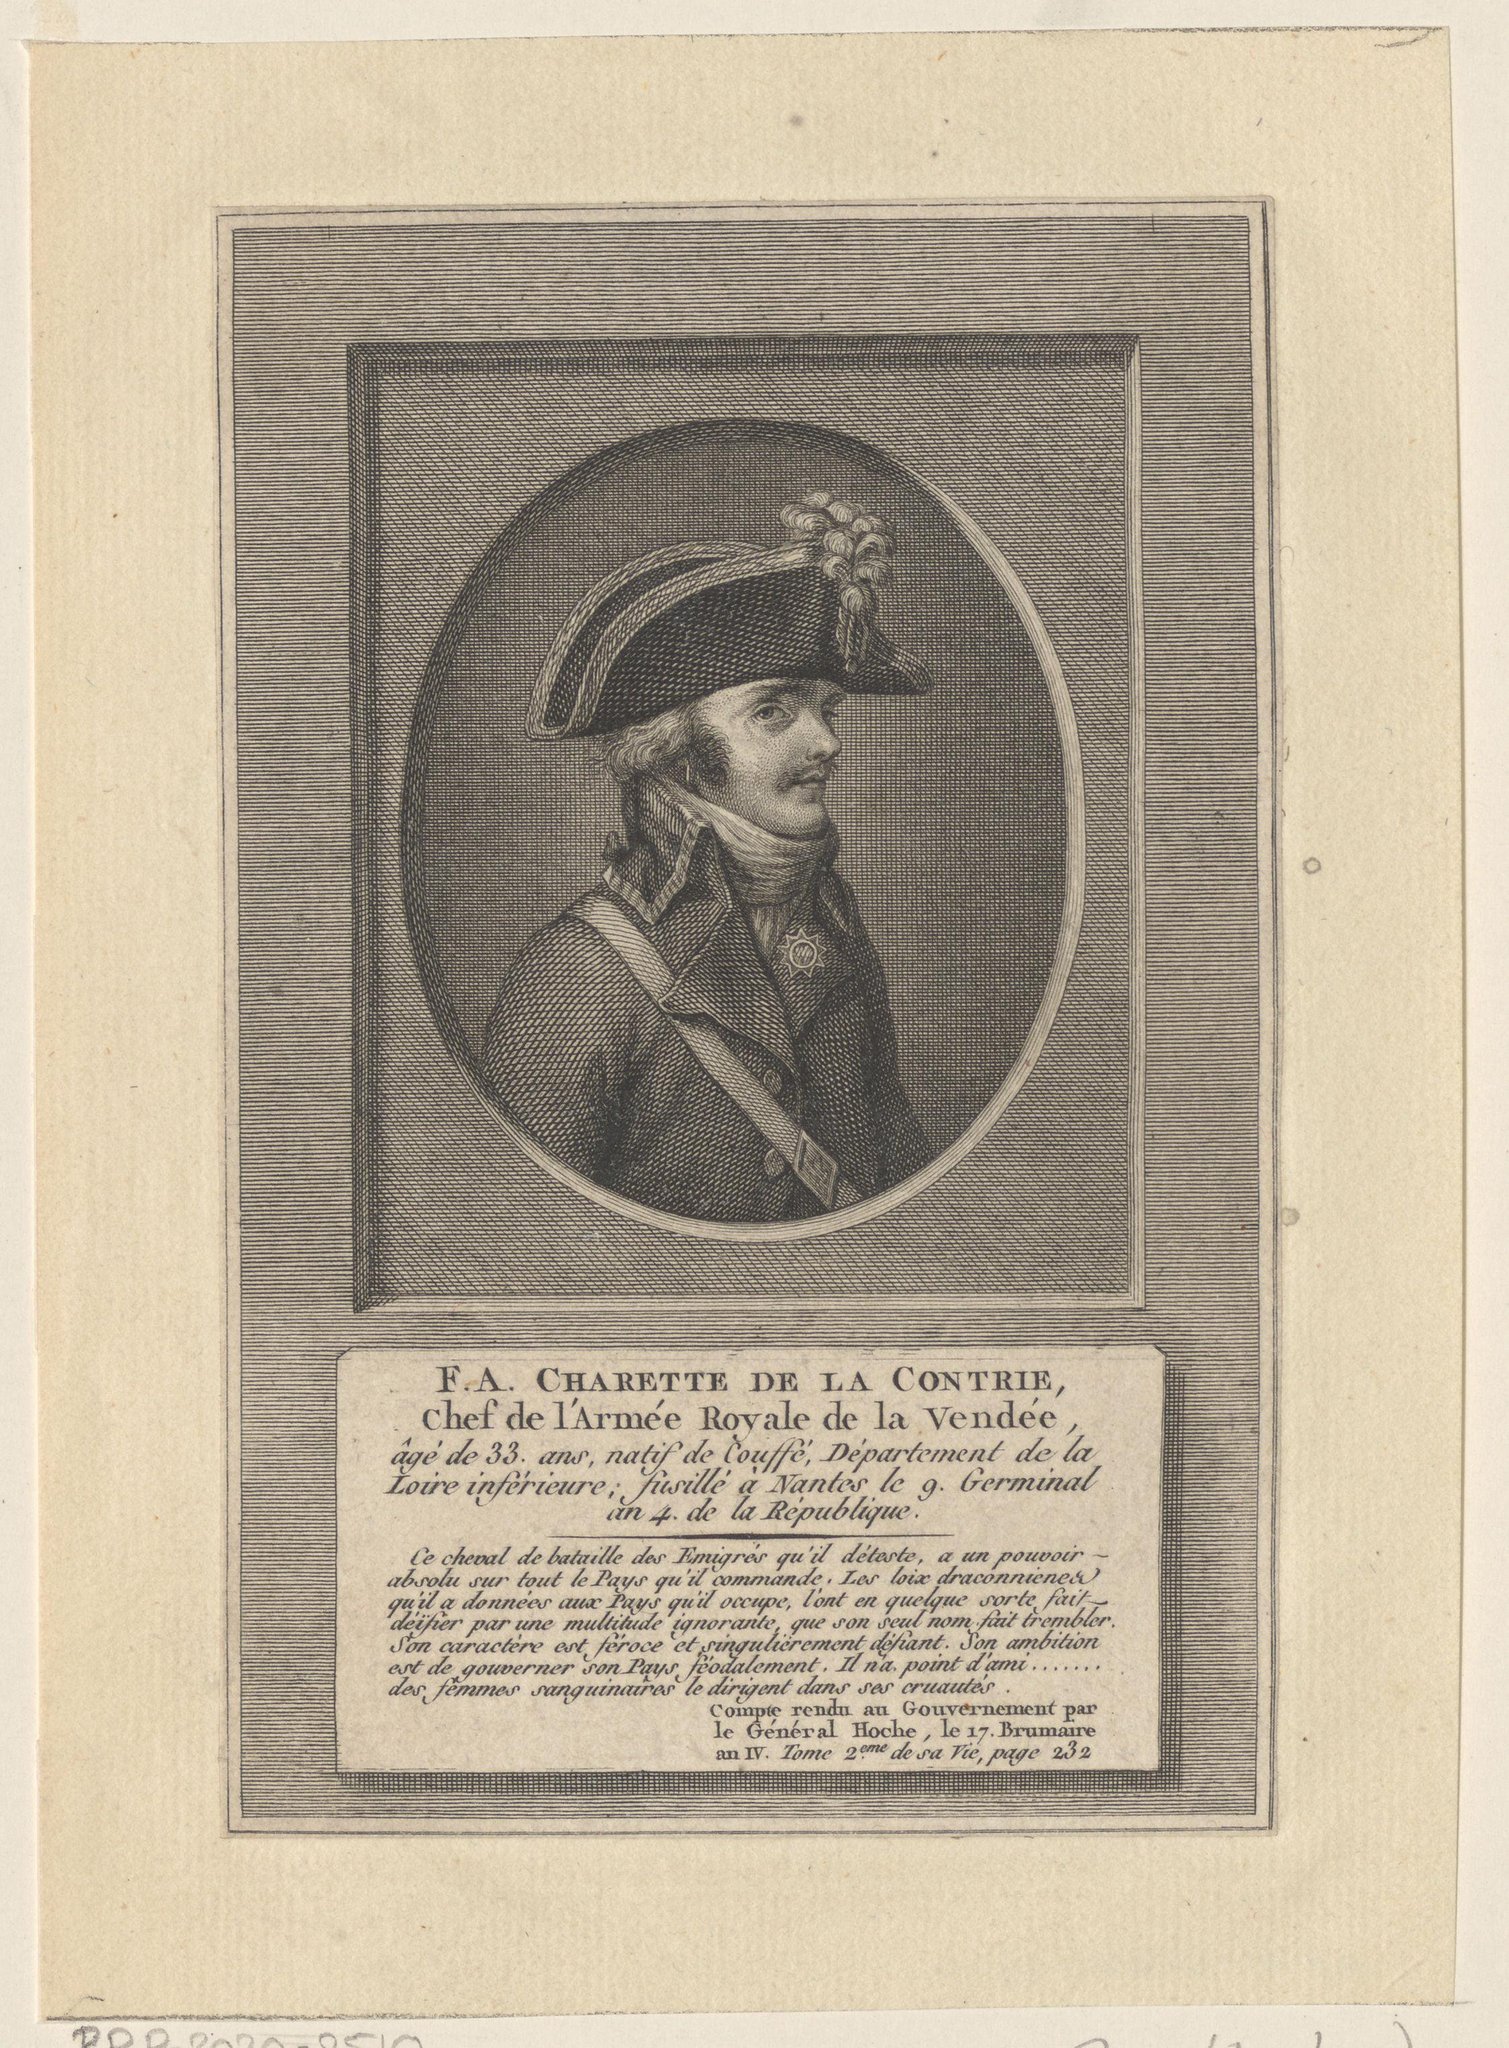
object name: print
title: Portret van François-Athanase Charette de la Contrie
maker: Anonymous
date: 1799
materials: paper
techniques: engraving, snipping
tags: historical persons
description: Prent mogelijk uit: Correspondance secrète (...). 2 dln. Parijs: François Buisson, 1799.